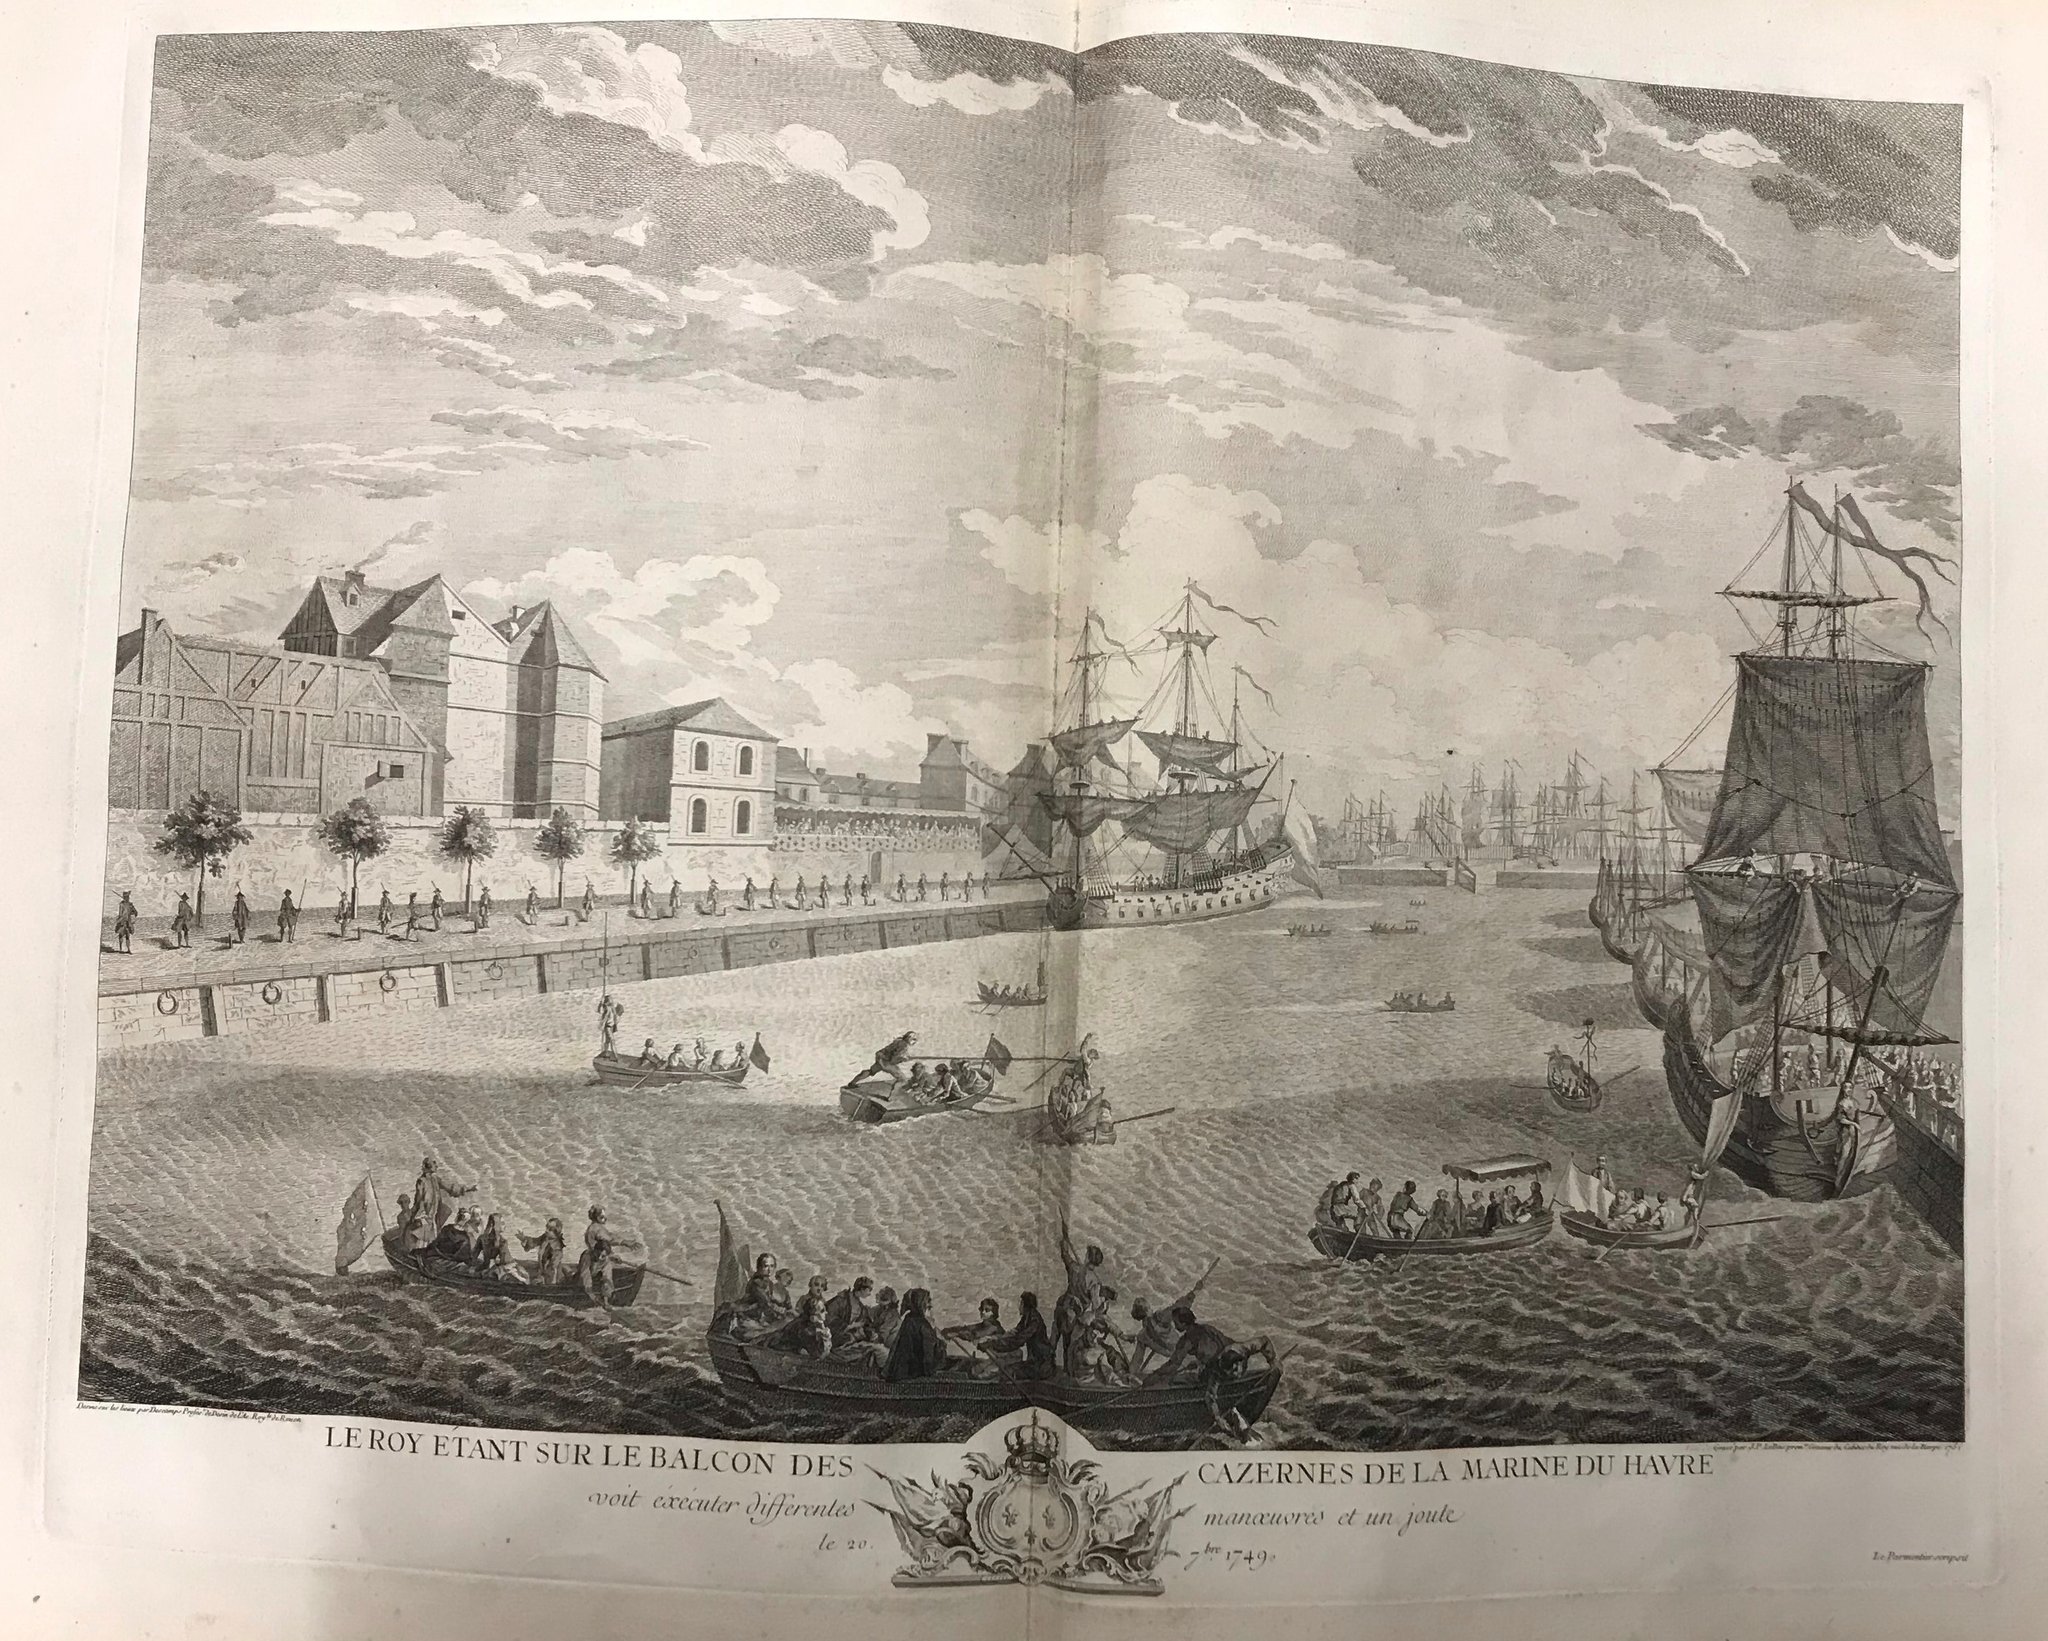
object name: book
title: Relation de L'Arrivée du Roi au Havre-de-Grace le 19 Septembre 1749 et les fêtes qu se sont données a cette occasion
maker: jean-baptiste descampes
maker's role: artist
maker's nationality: french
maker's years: 1706-1791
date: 1753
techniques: engraving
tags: boats,ships